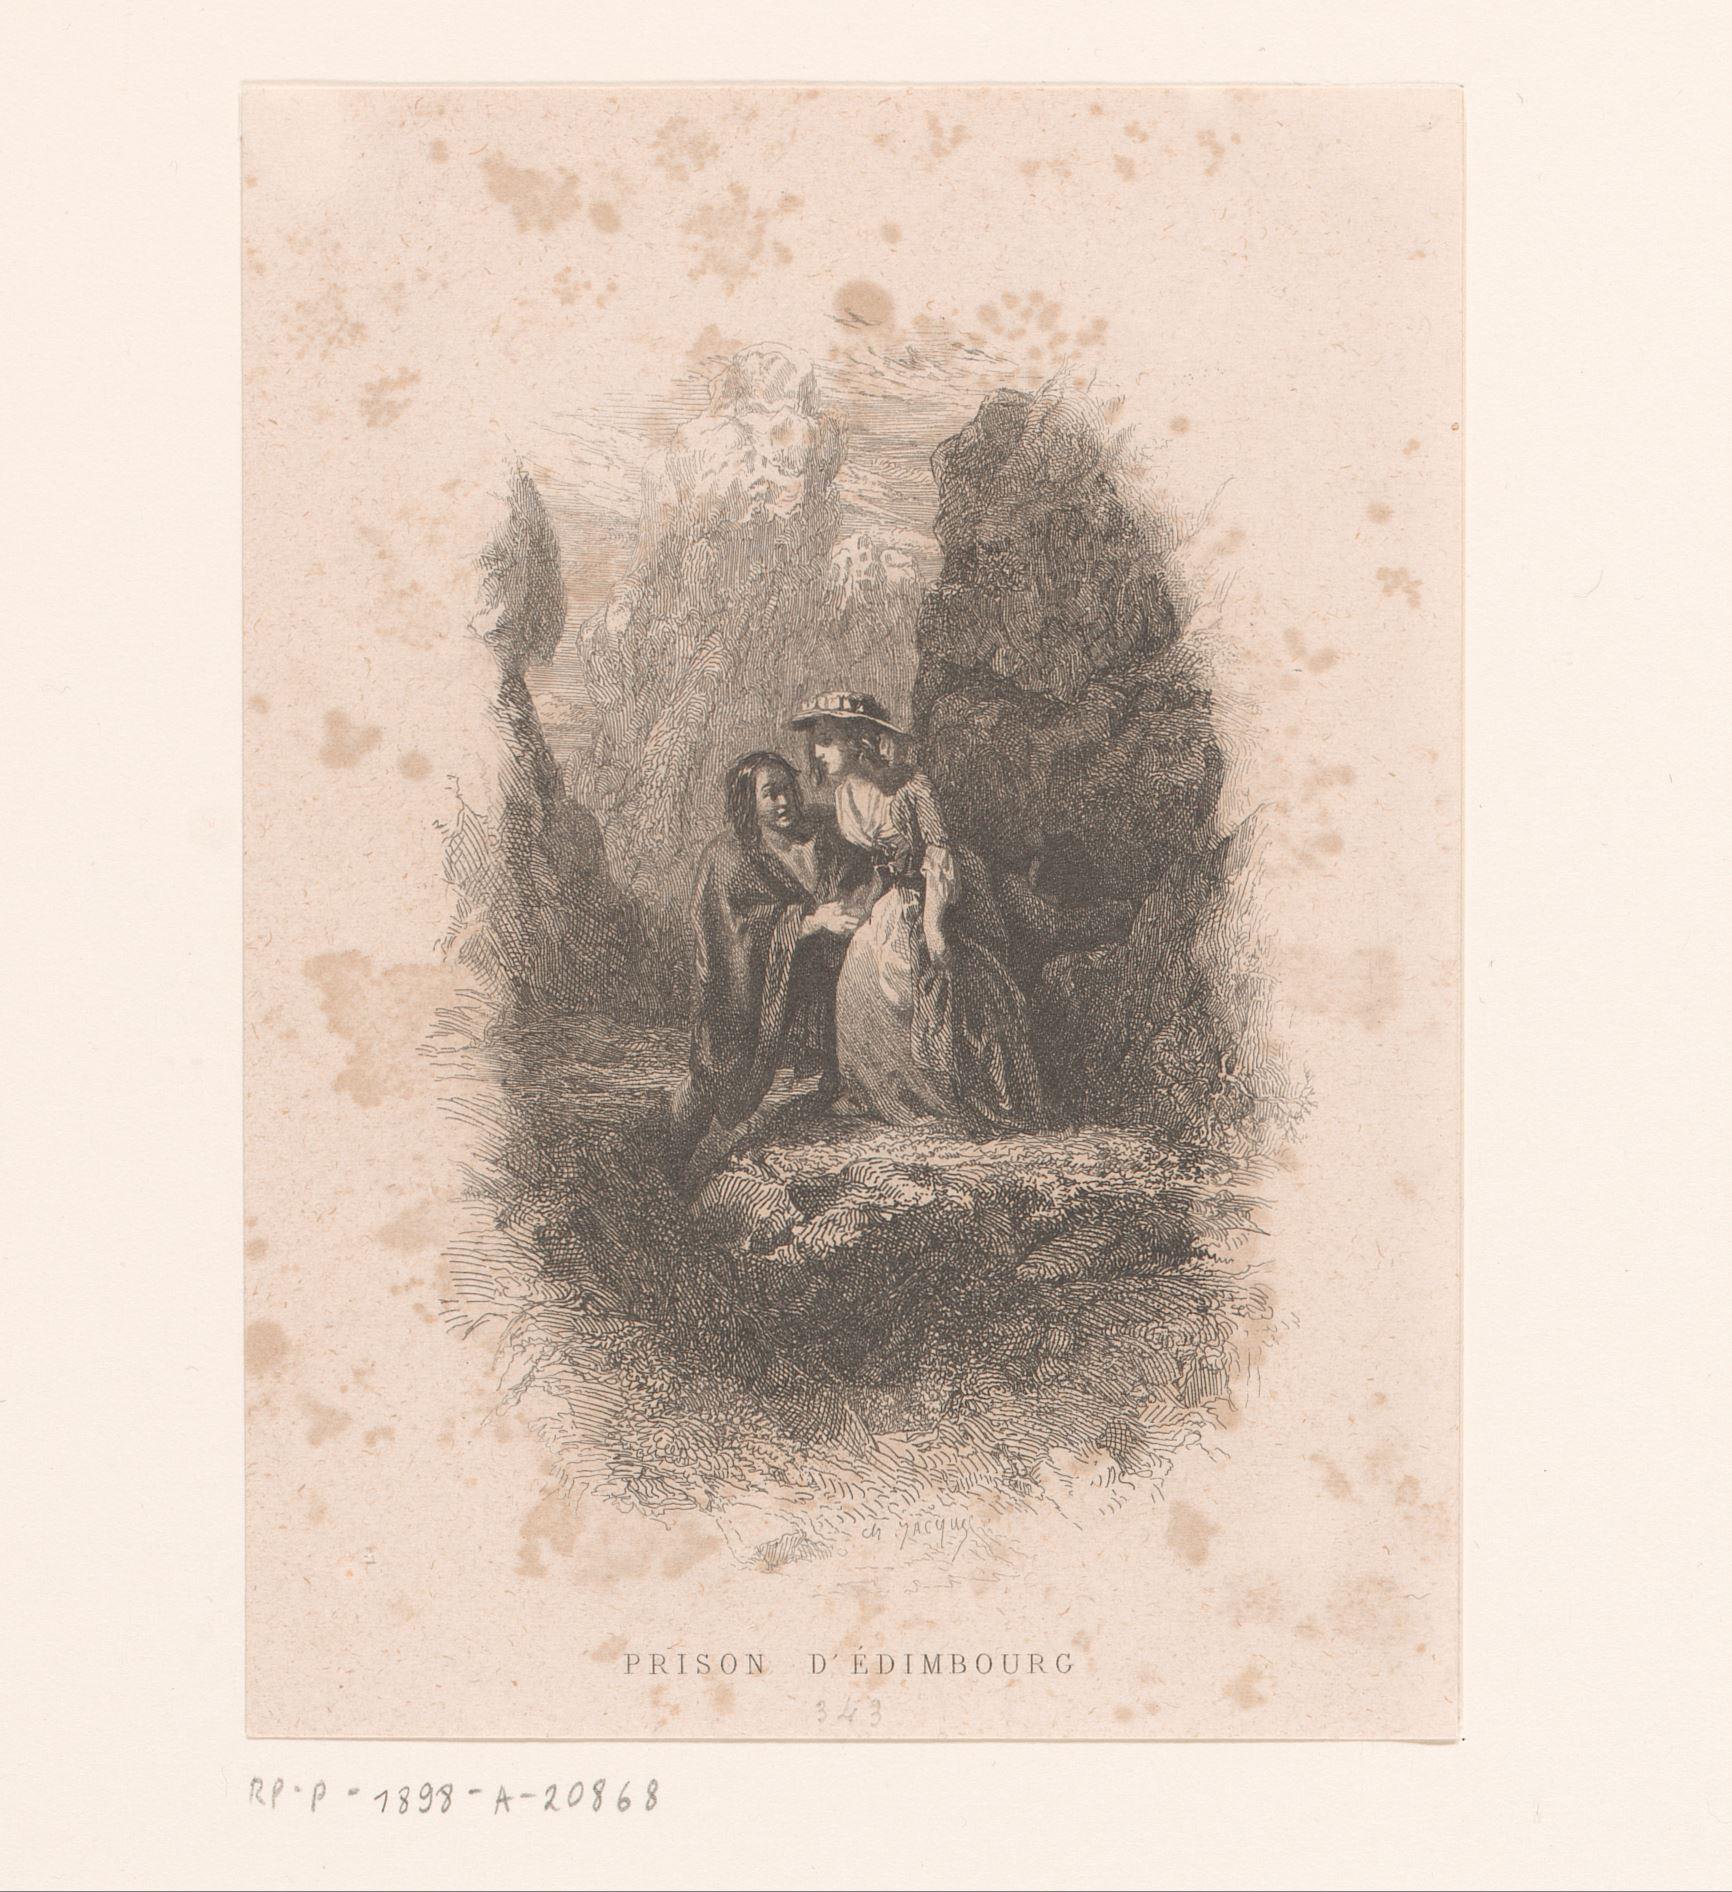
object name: book illustration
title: Koppel in een rotsachtig landschap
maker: charles emile jacque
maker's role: draughtsman, painter, print maker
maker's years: 1813-1894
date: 1844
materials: paper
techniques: etching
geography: france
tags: couple of lovers, mountains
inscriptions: collector's mark: Lugt 964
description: Prent uit: Oeuvres de Walter Scott. Parijs: Firmin-Didot, 1844.